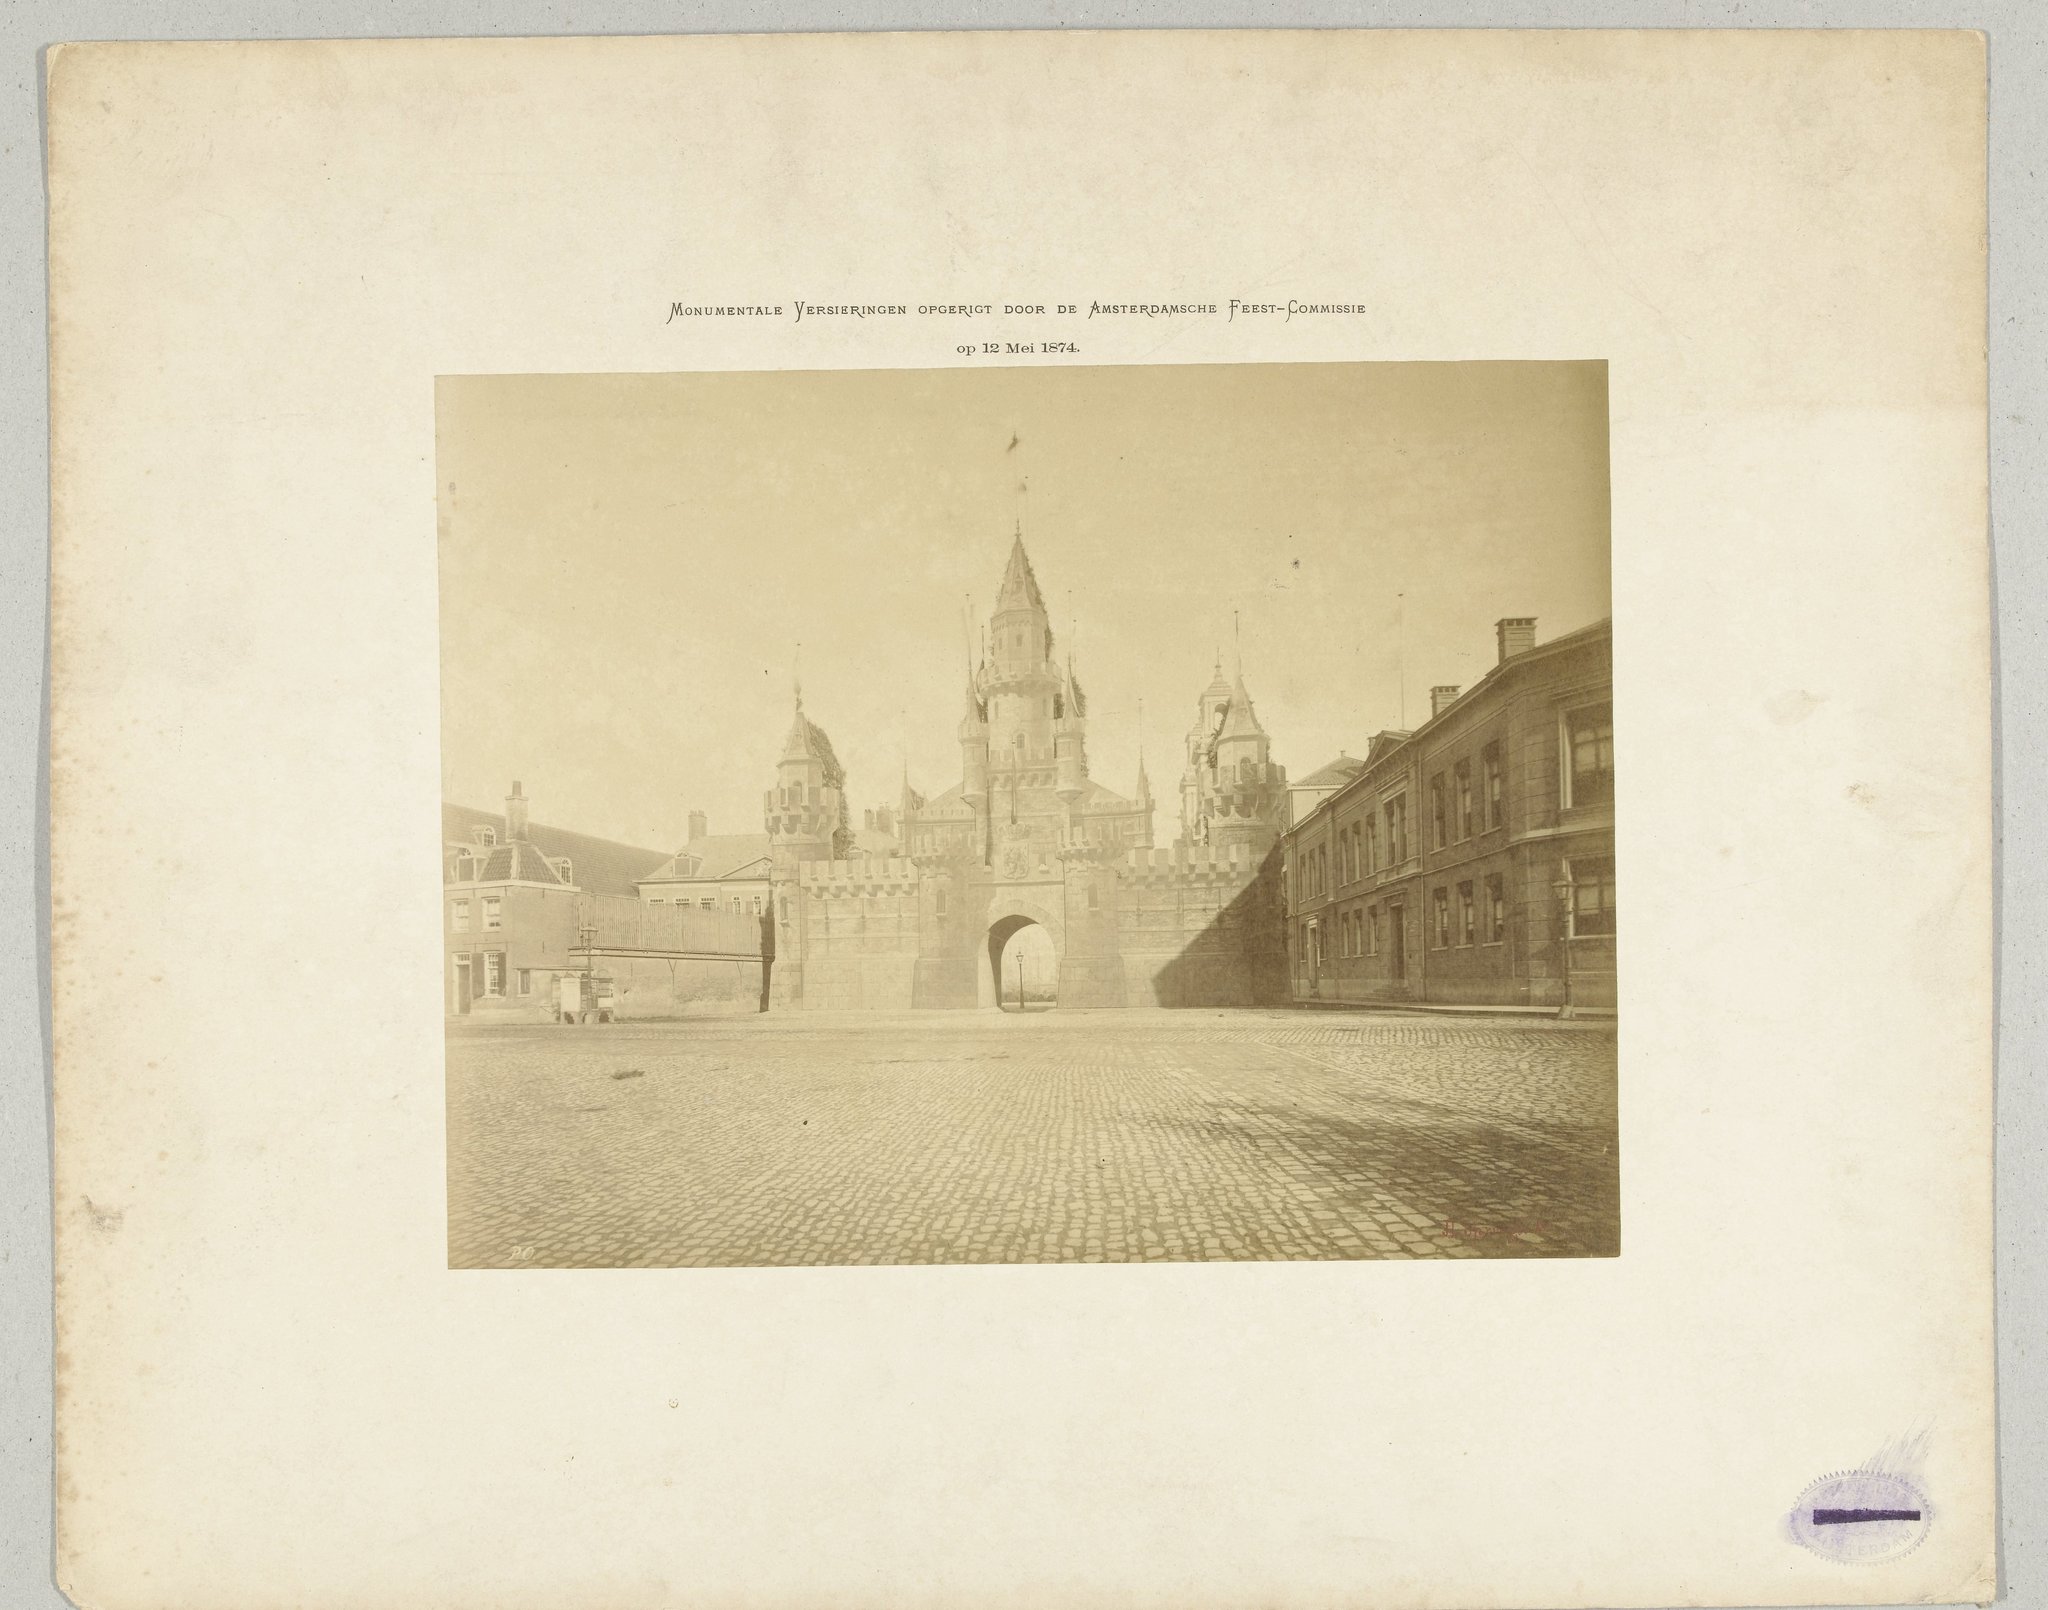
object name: photograph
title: Versieringen (poortwerk) in Amsterdam ter gelegenheid van het 25-jarig regeringsjubileum van koning Willem III in 1874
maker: pieter oosterhuis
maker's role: draughtsman, print maker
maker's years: 1816-1885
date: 1874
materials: cardboard, paper, photographic support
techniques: albumen print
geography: amsterdam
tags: brussels, willem iii (koning der nederlanden), festivities, amsterdam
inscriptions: signature and date: ‘Linksonder in negatief: PO; rechtsonder op de afdruk J.L. Springer A.te’